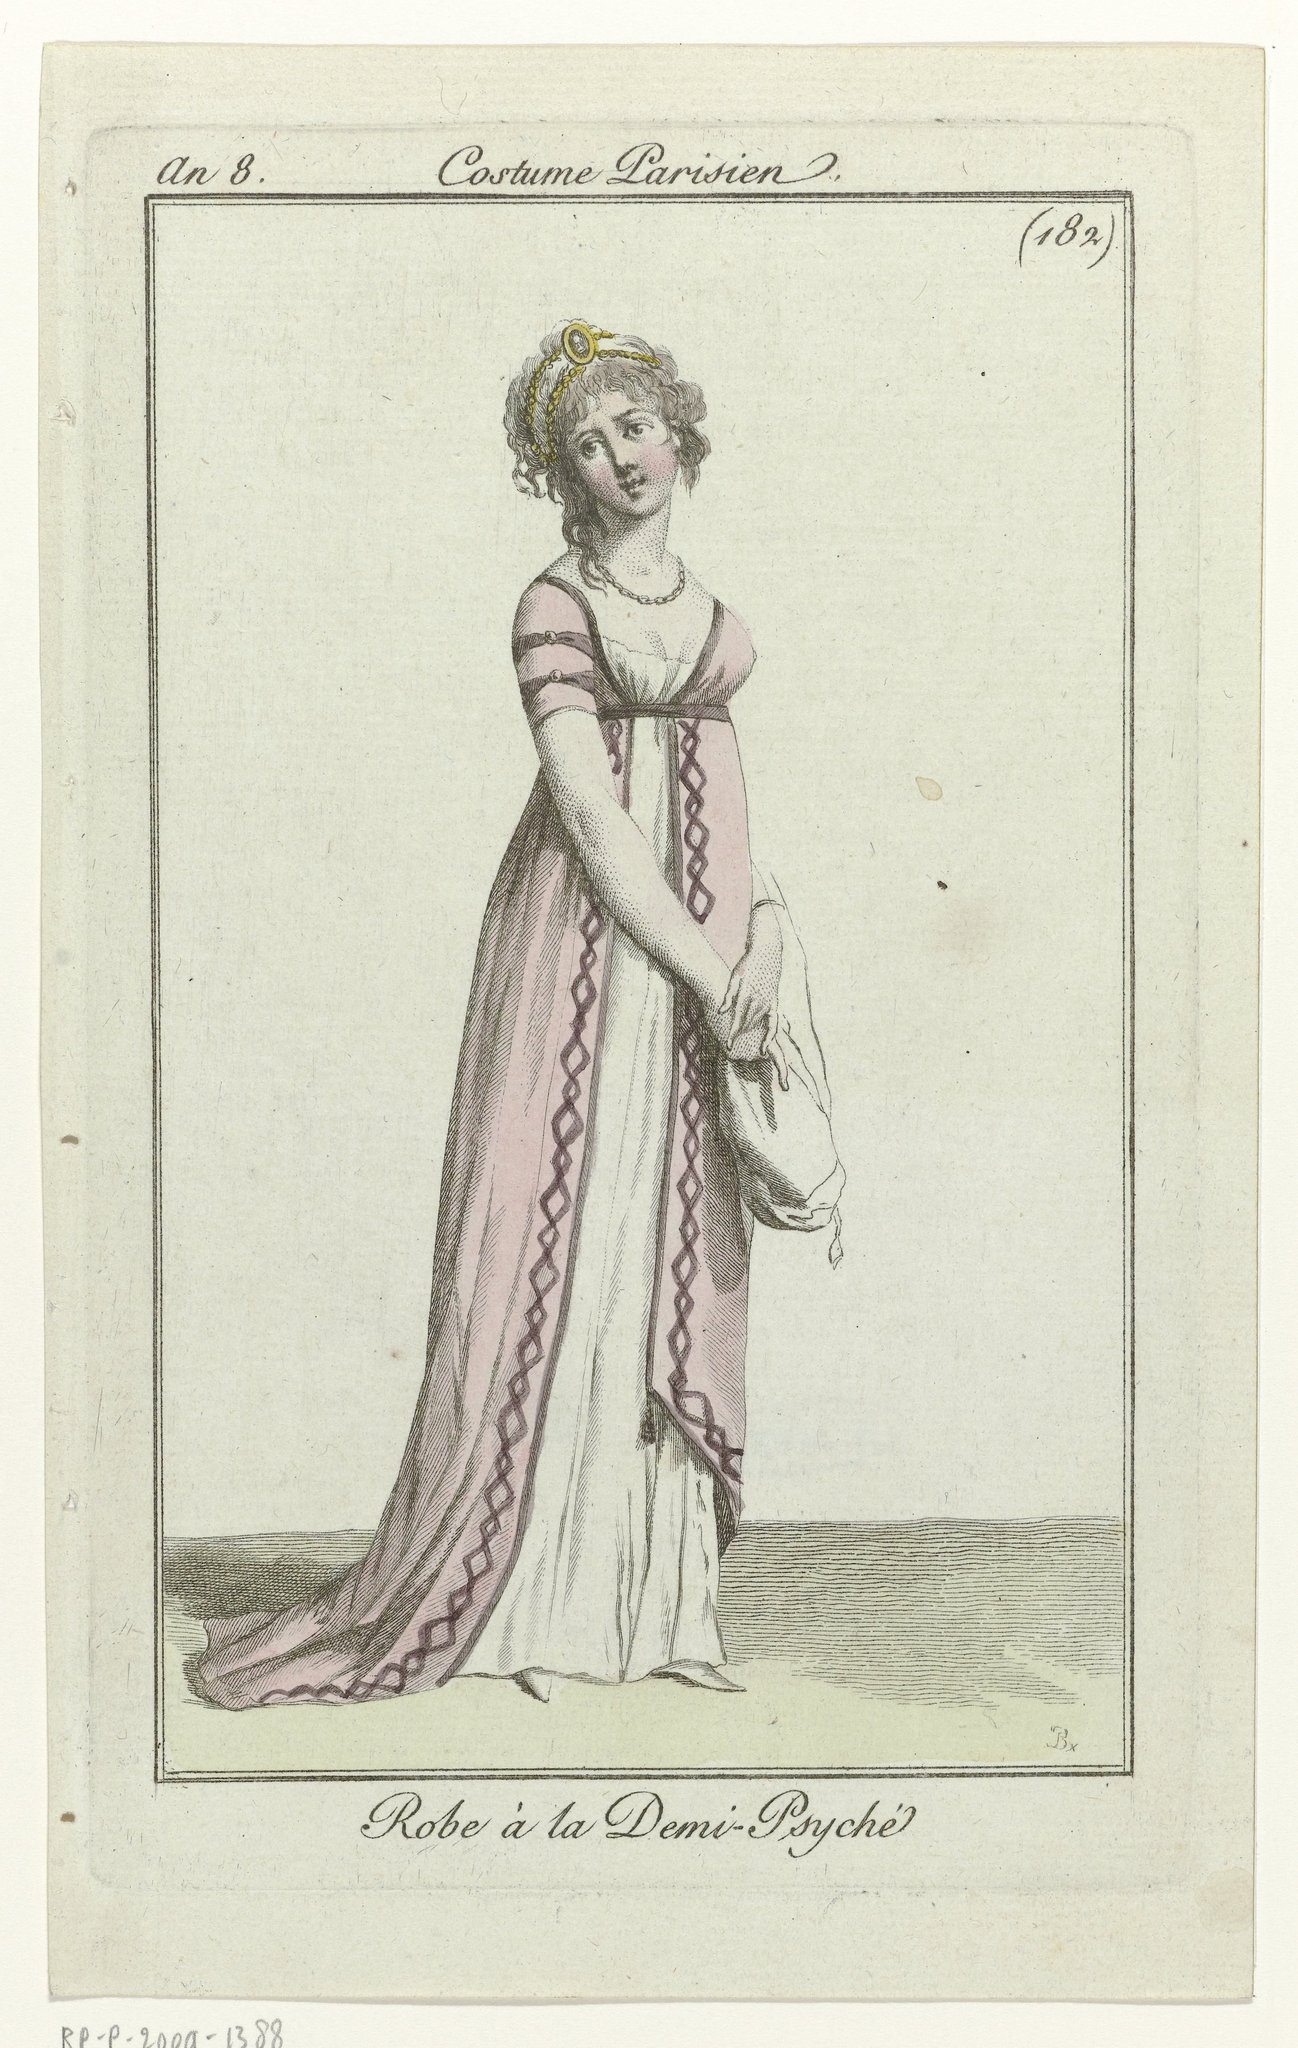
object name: fashion print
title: Journal des Dames et des Modes, Costume Parisien, 26 décembre 1799, An 8 (182) : Robe à la Demi-Psyché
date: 1799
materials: paper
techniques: engraving, hand coloring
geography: paris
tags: diadem, tiara (+ women's clothes), bag (reticule) (+ women's clothes), fashion plates, dress, gown (+ women's clothes), necklace (+ women's clothes)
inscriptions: caption: ‘Robe à la Demi-Psyché’, title: ‘Costume Parisien.’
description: Japon 'à la Demi-Psyché', bij de zoom versierd met geometrische motief. Accessoires: haarband met ovaal medaillon, collier, reticule of buidel, platte schoenen met puntige neuzen. De prent maakt deel uit van het modetijdschrift Journal des Dames et des Modes, uitgegeven door Pierre de la Mésangère, Parijs, 1797-1839.